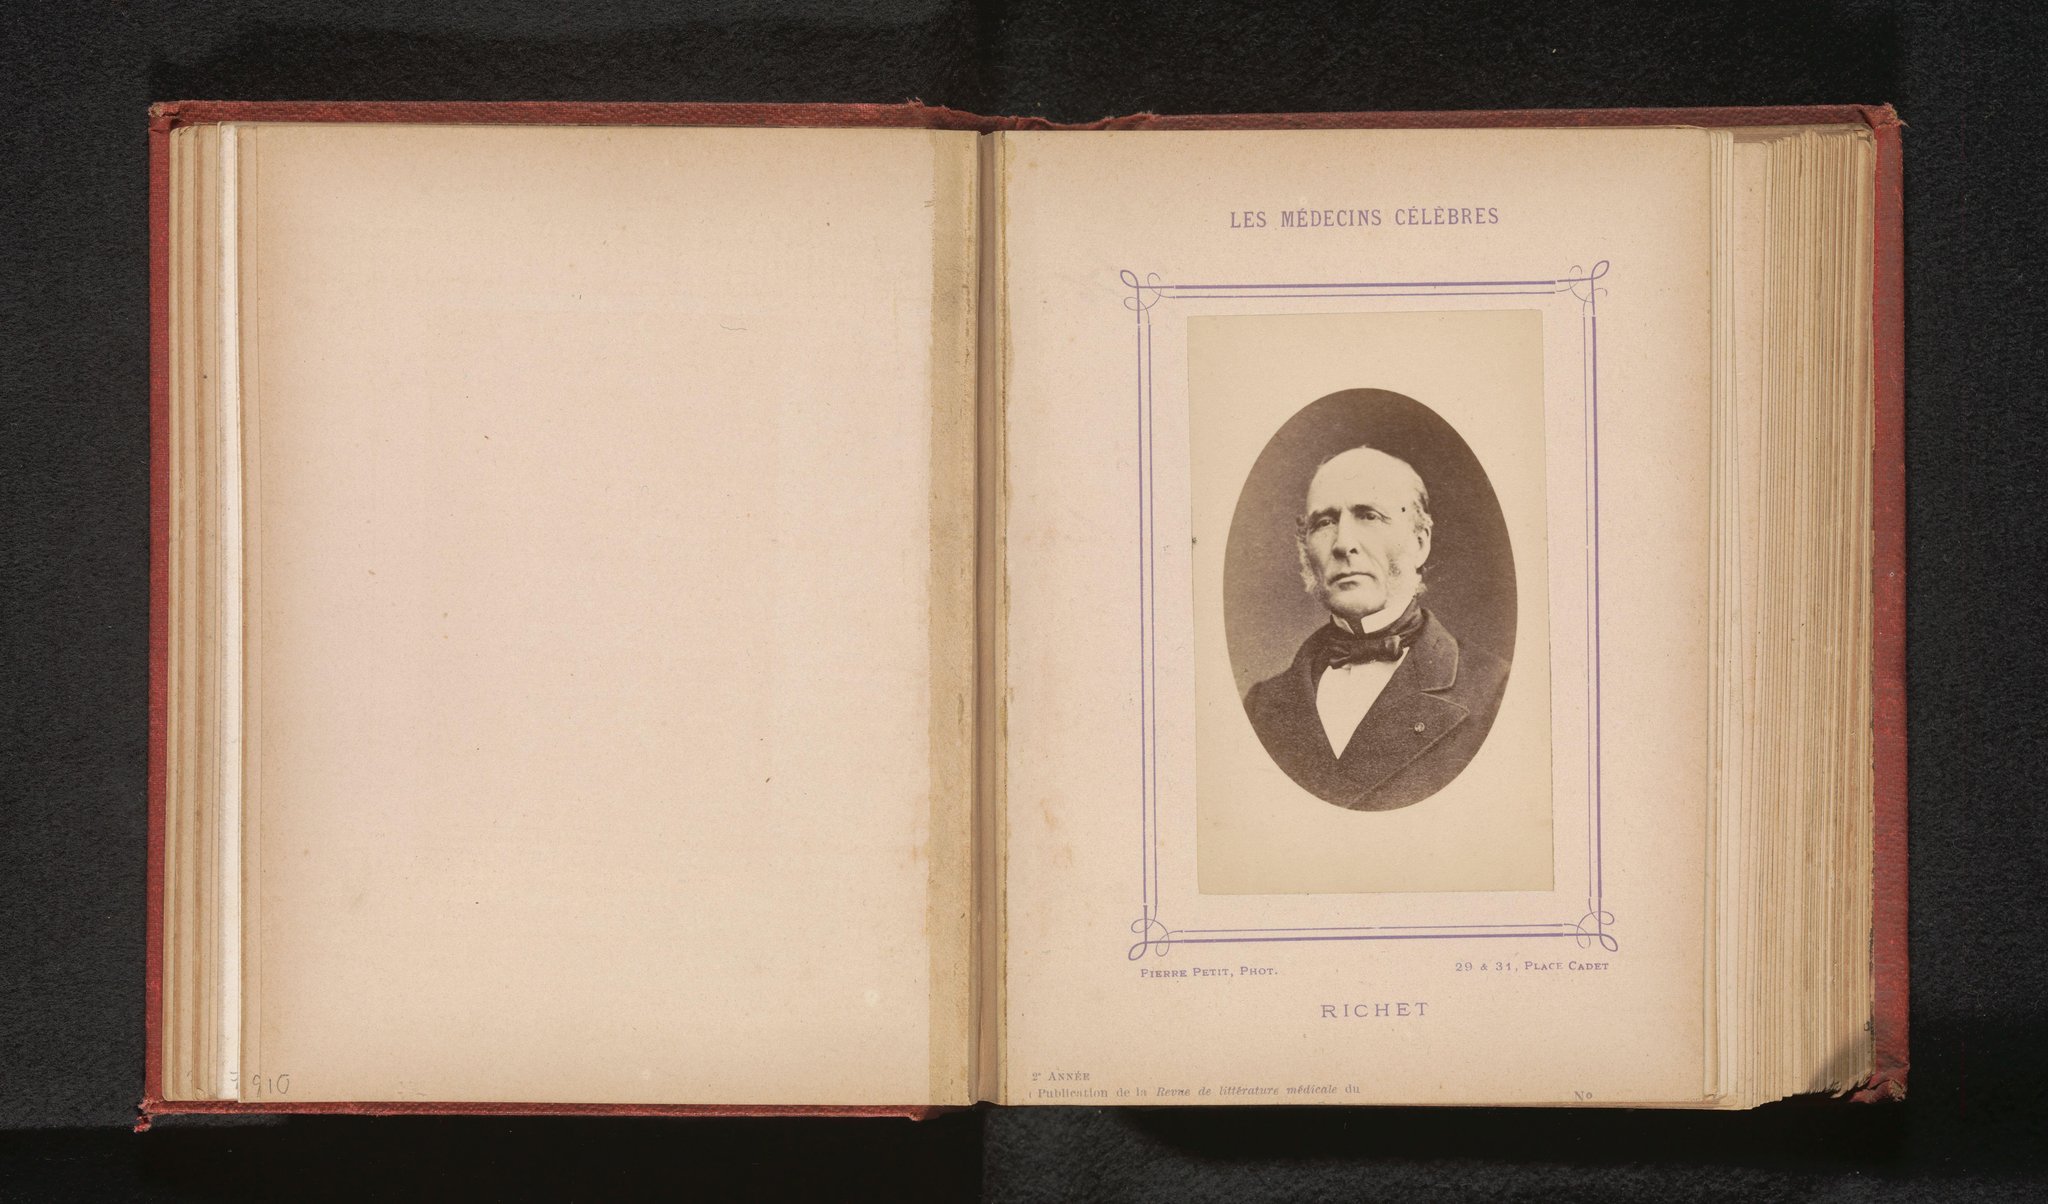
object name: photograph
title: Portret van Alfred-Louis-Dominique Richet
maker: pierre petit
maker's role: fotograaf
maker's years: 1832-1909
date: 1871-1879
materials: paper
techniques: albumen print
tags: adult man, historical persons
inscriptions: inscription: ‘(Publication de la Revue de litterature médicale du/ No.]’